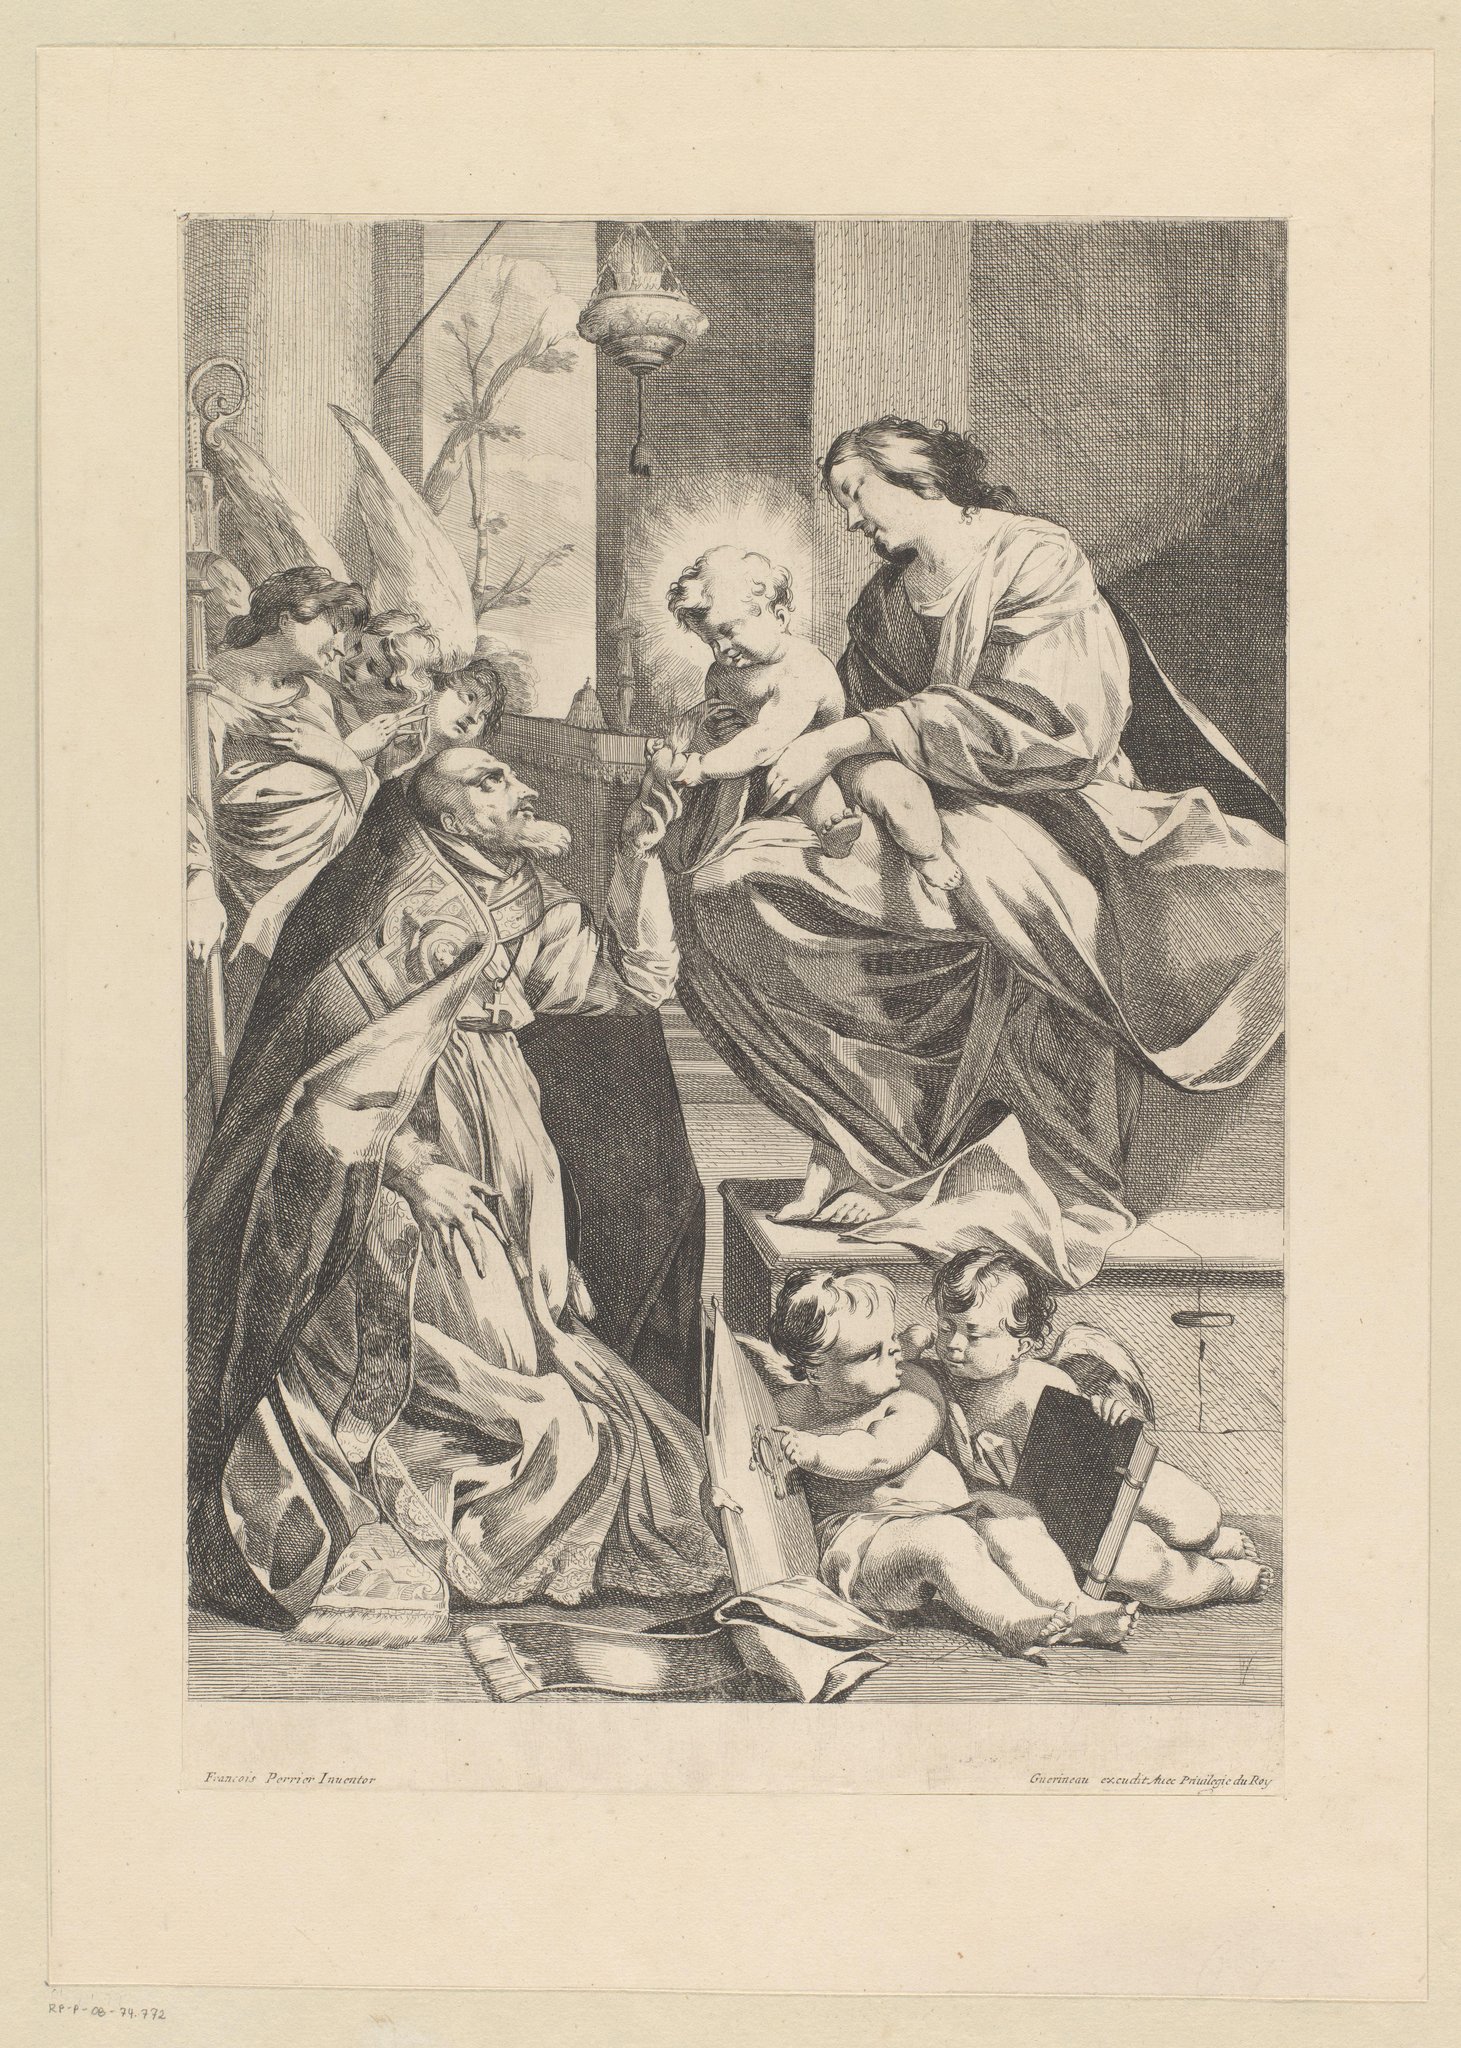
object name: print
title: Knielende bisschop biedt Kind op schoot van Maria een vlammend hart aan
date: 1615-1664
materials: paper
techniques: engraving, etching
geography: france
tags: archbishop, bishop, etc. (roman catholic), mary sitting or enthroned, the christ-child sitting on her knee (christ-child to mary's left) - ff - the christ-child to mary's right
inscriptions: collector's mark: Lugt 240